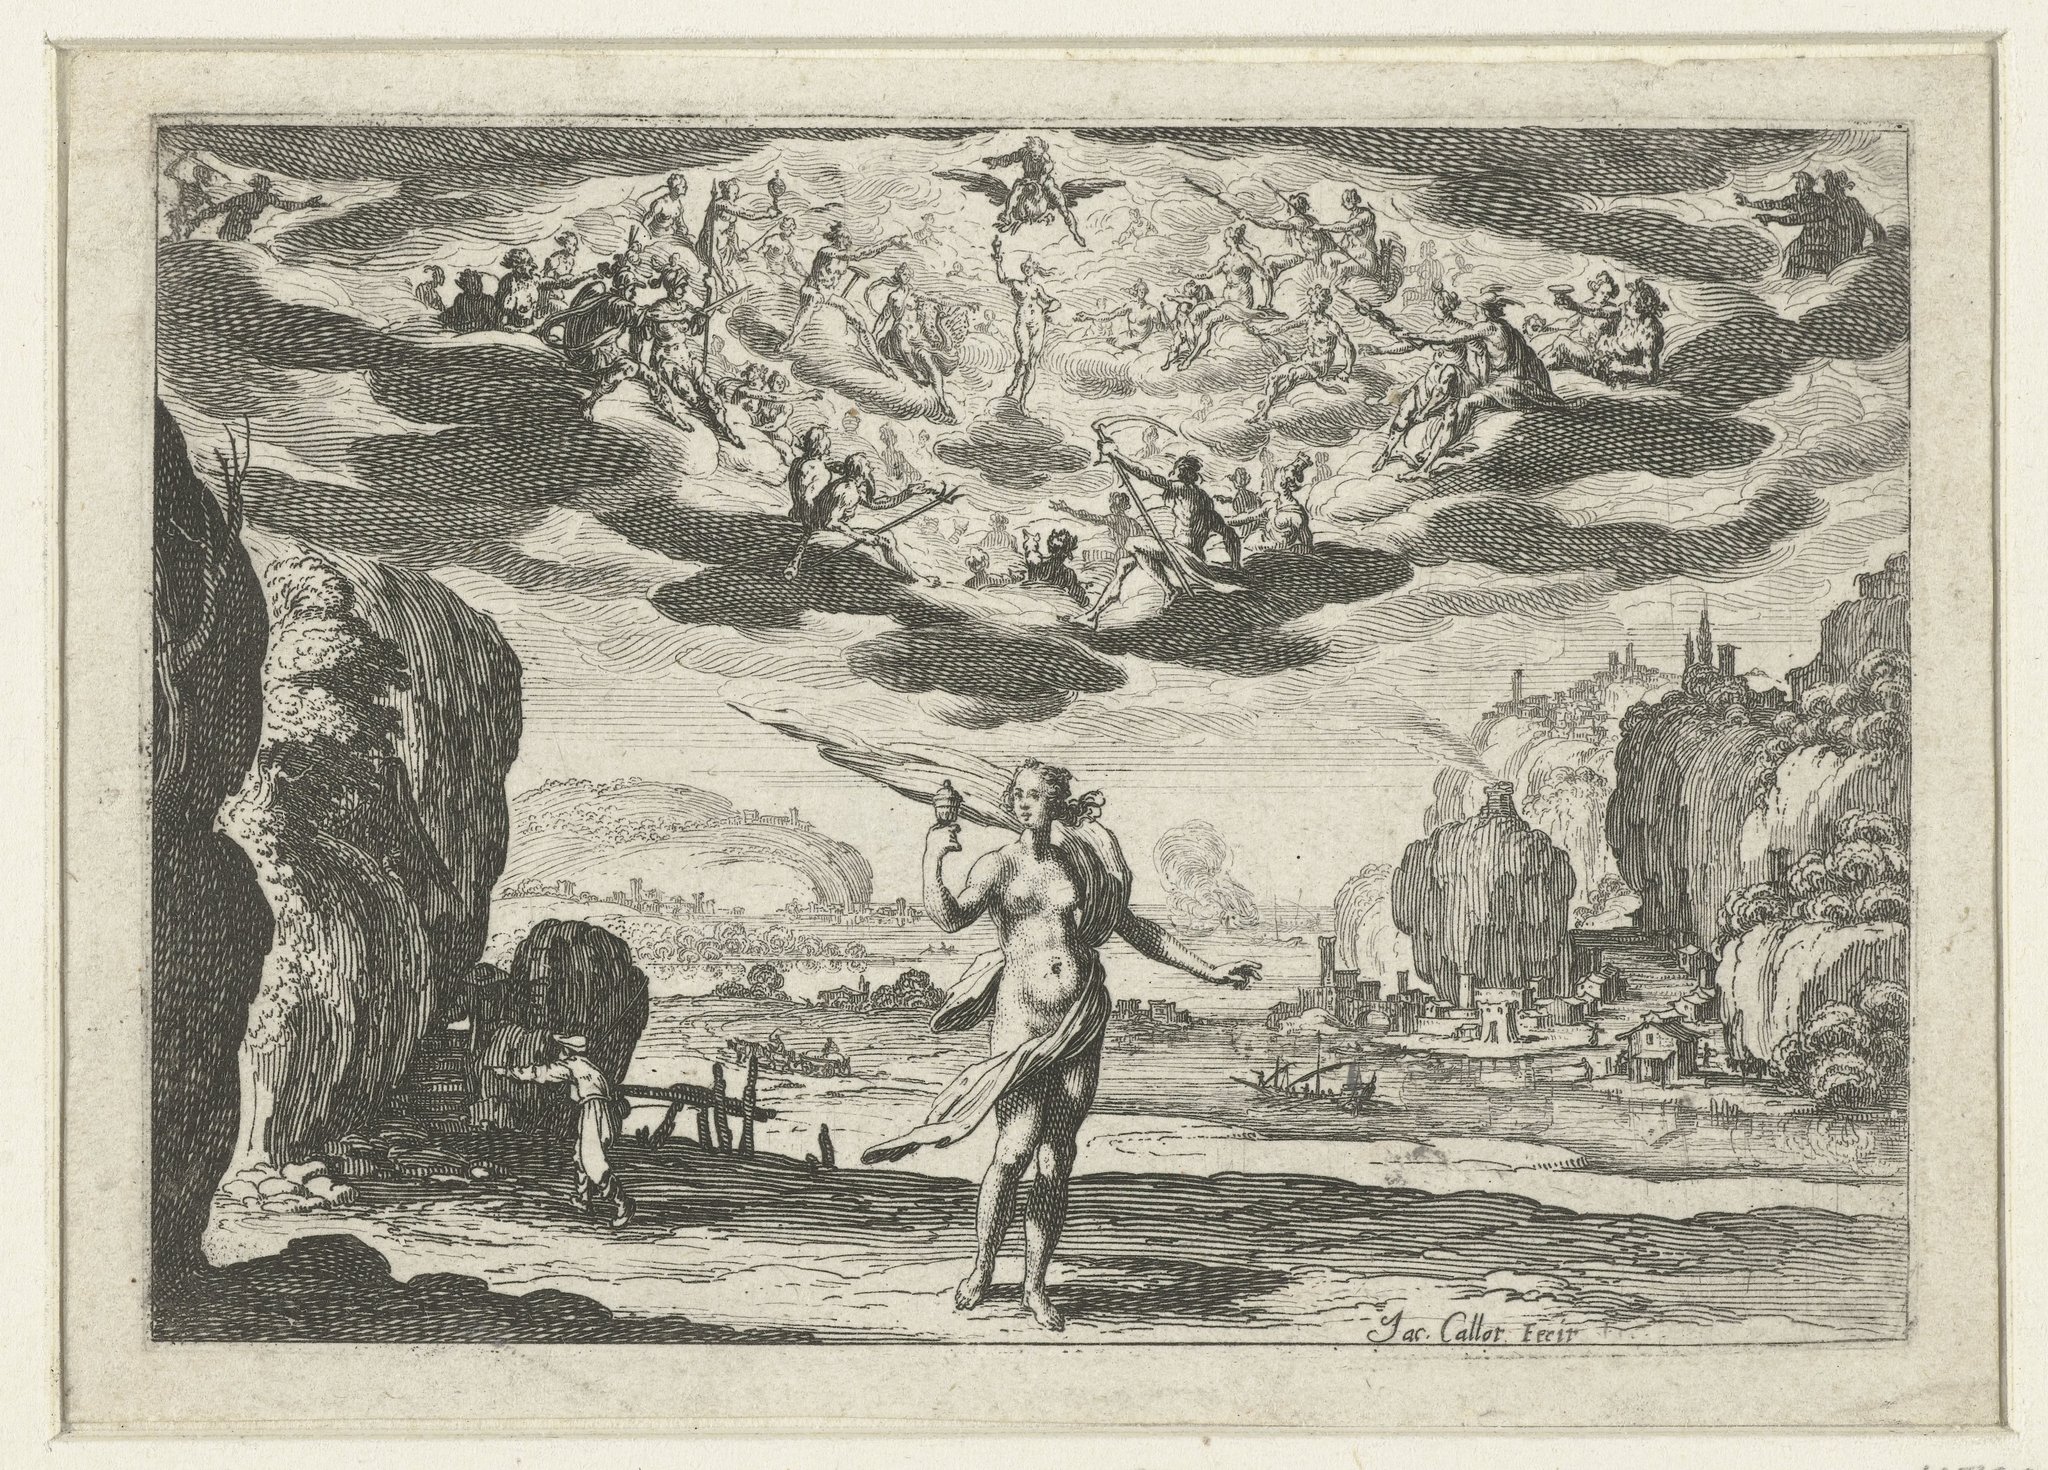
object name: print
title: Pandora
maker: jacques callot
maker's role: draughtsman, print maker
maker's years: 1592-1635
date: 1625-1626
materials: paper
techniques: etching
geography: nancy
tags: the gods adorning pandora, (story of) pandora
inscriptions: collector's mark: Lugt 240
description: In een berglandschap staat een vrijwel naakte vrouw met een gesloten beker in de rechterhand. Aan de hemel op een wolkenpartij is zij nogmaals zichtbaar, omringd door Olympische goden.